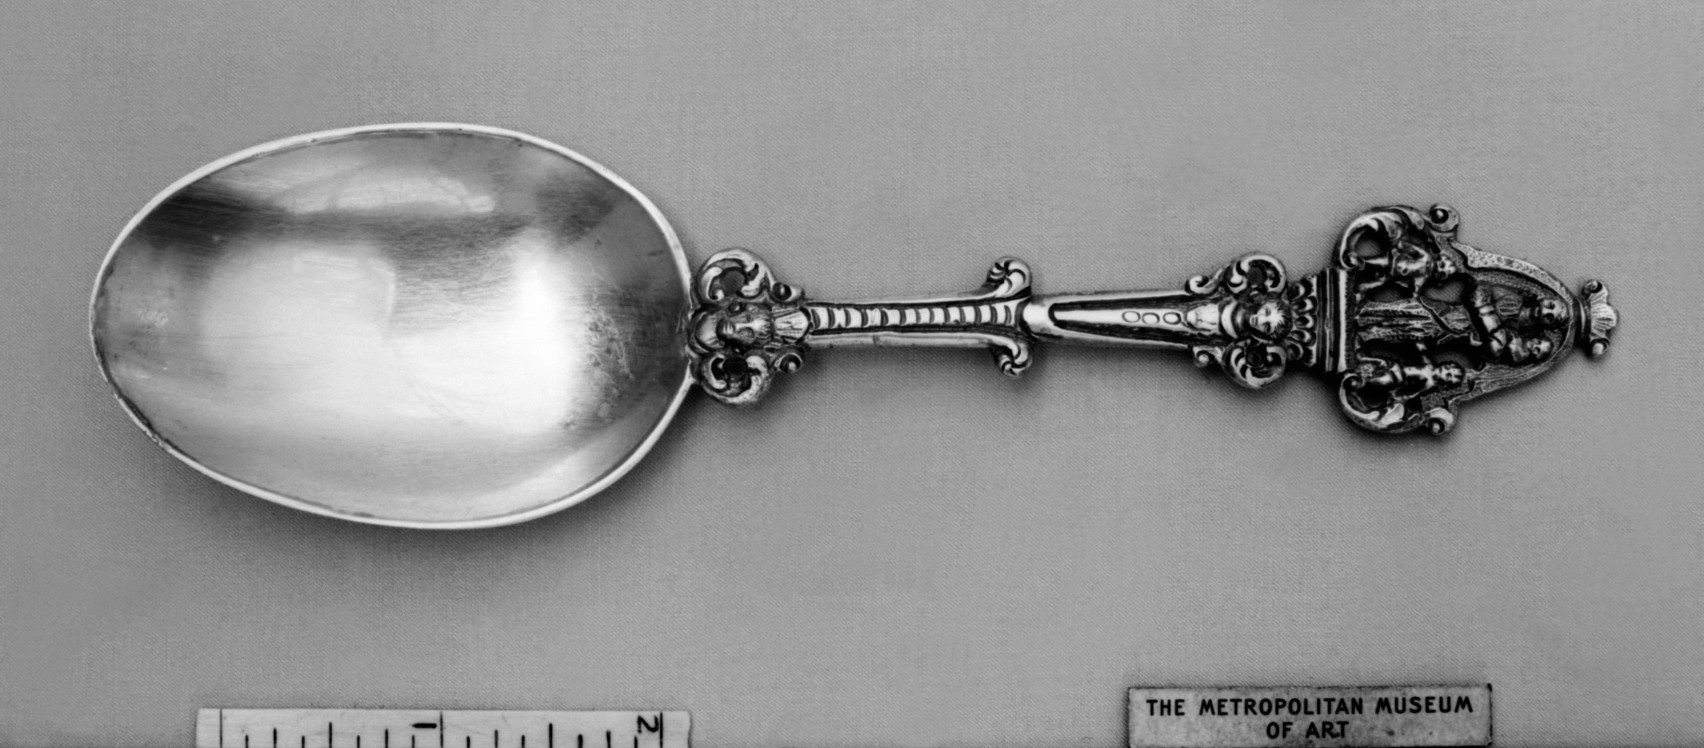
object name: spoon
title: Figure-top spoon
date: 1734-1766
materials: silver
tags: children